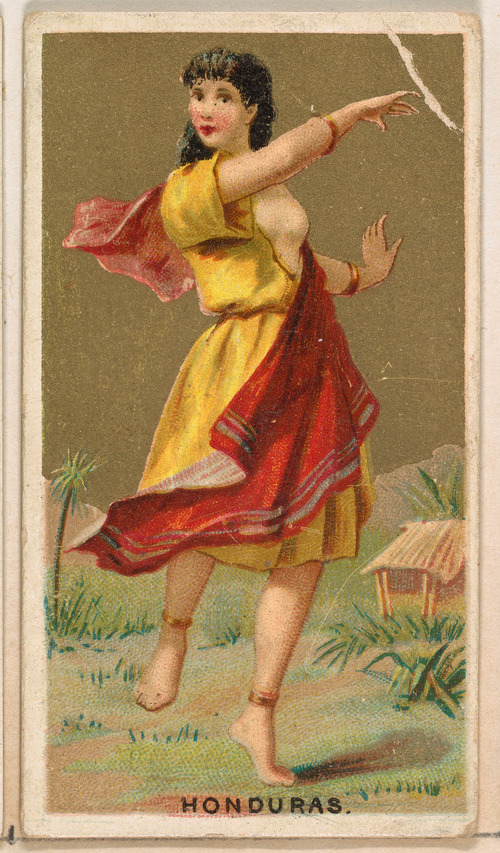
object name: print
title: Honduras, from the Dancing Girls of the World series (N185) issued by Wm. S. Kimball & Co.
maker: william s. kimball & company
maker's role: publisher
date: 1889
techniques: color lithograph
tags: women,dancing,dancers